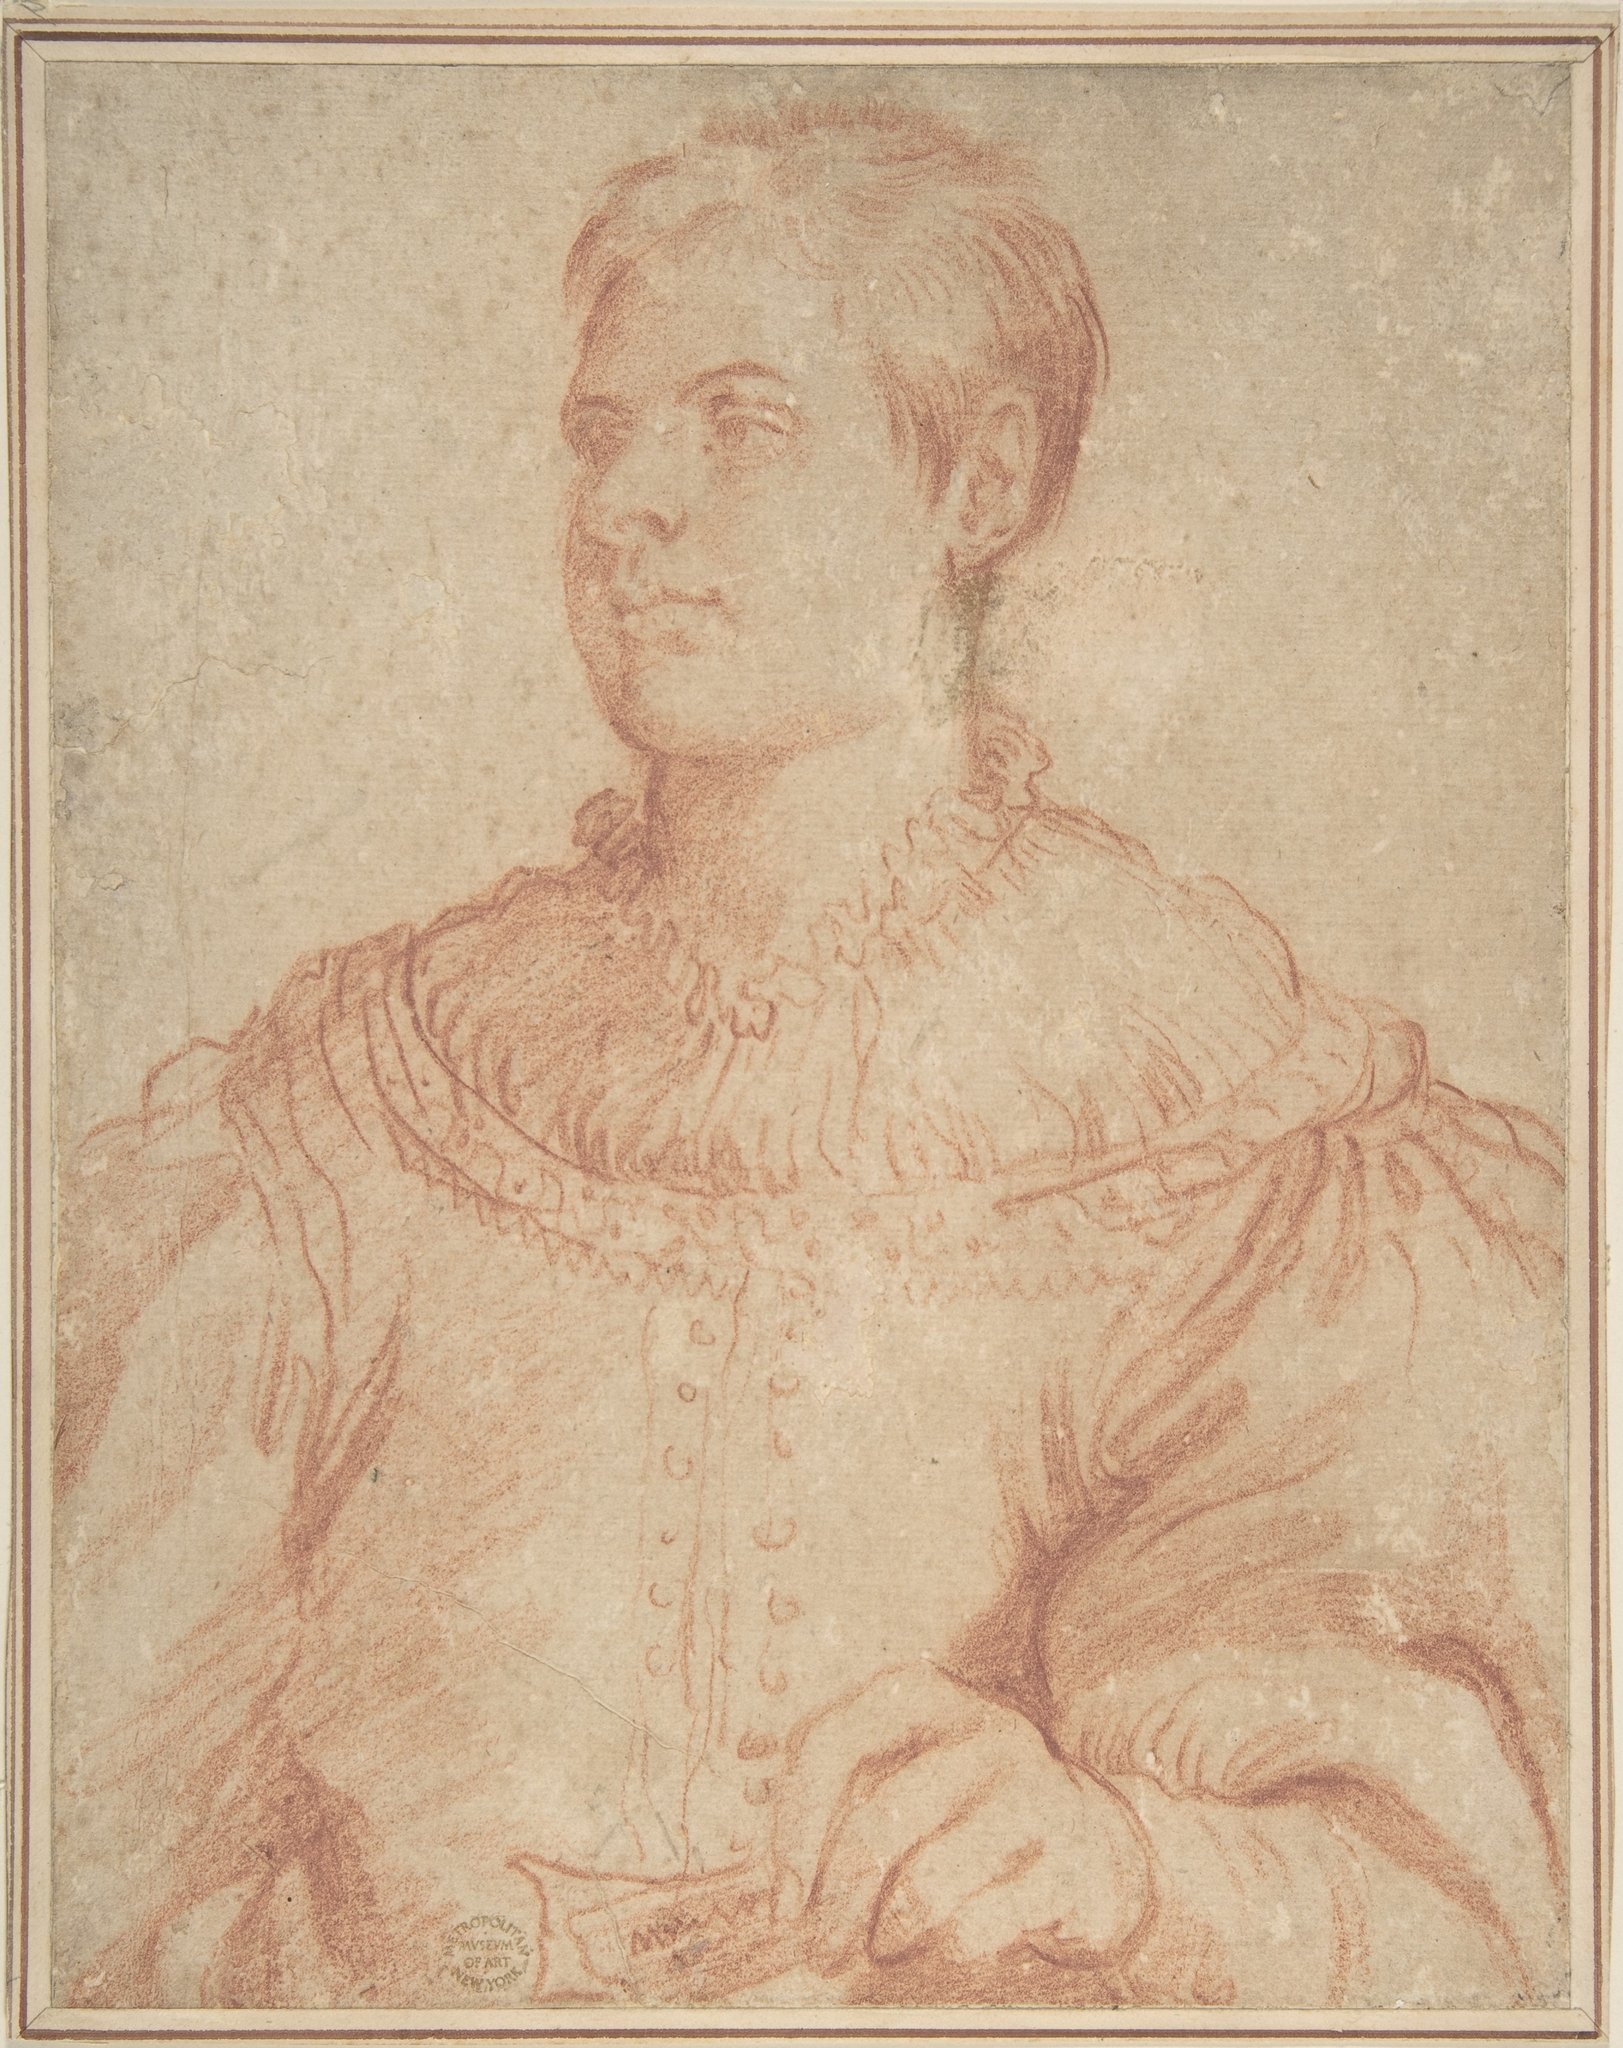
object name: drawing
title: Portrait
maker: anonymous, italian, roman-bolognese, 17th century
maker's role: artist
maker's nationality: italian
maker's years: 1600-1700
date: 1601-1700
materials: chalk, paper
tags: men,portraits